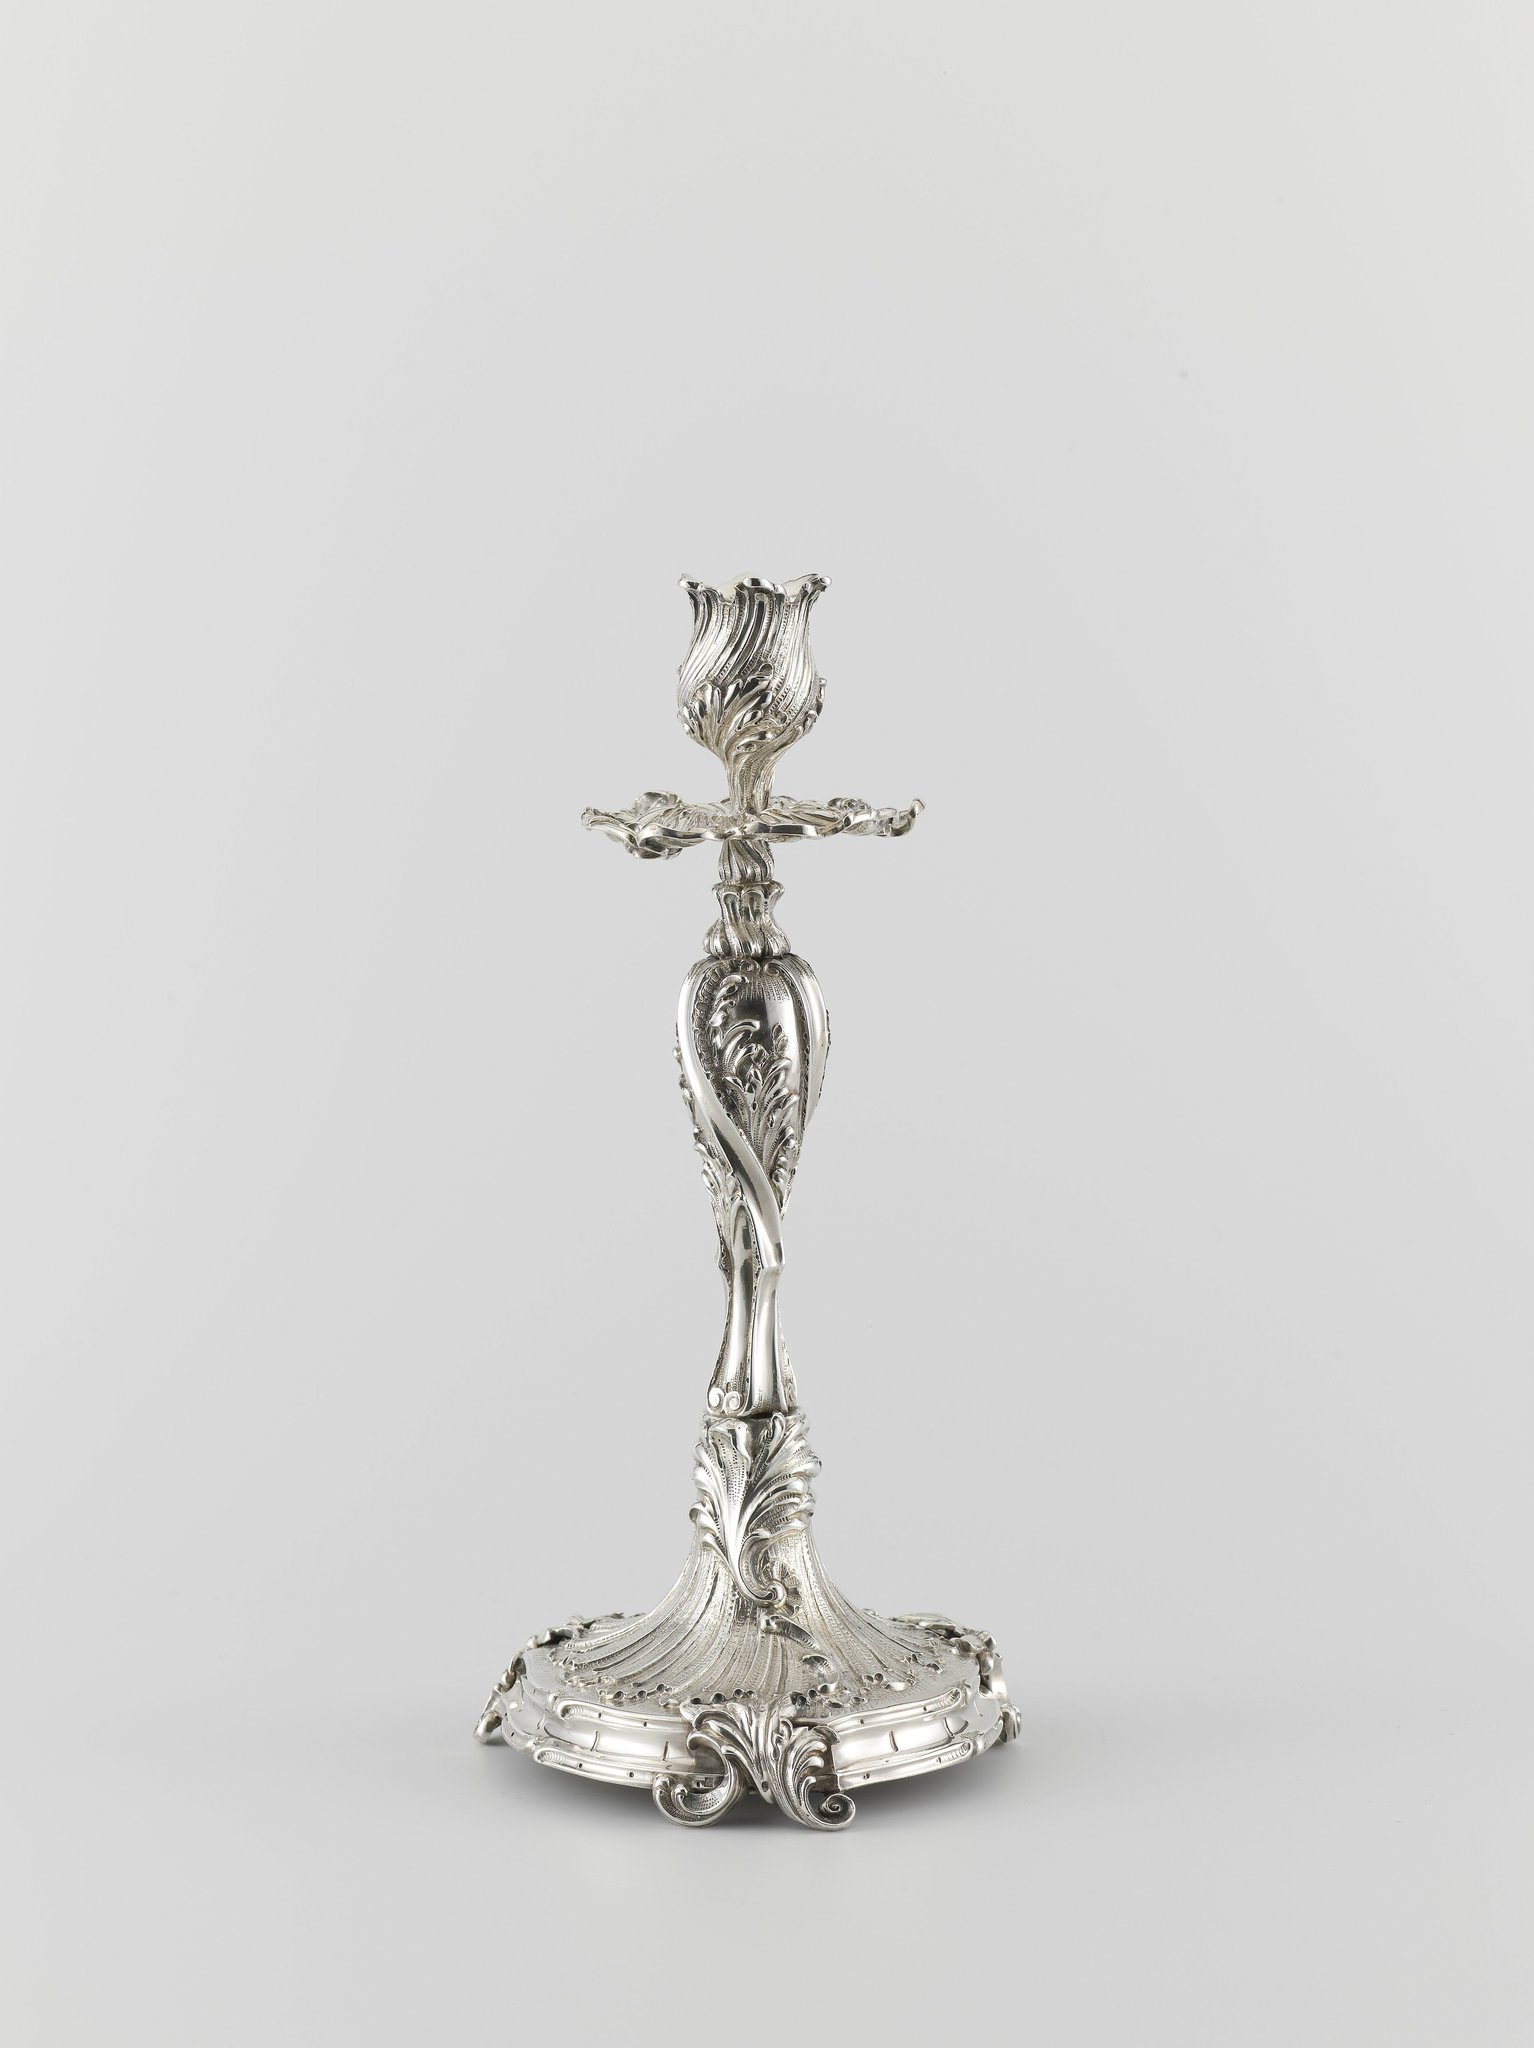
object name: candlestick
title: Kandelaar, deel van een ensemble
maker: karel sluijterman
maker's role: designer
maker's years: 1863-1931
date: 1891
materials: silver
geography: amsterdam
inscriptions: maker's mark, assay office mark, alloy mark, assayer's mark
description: Kandelaar van zilver, deel van een ensemble